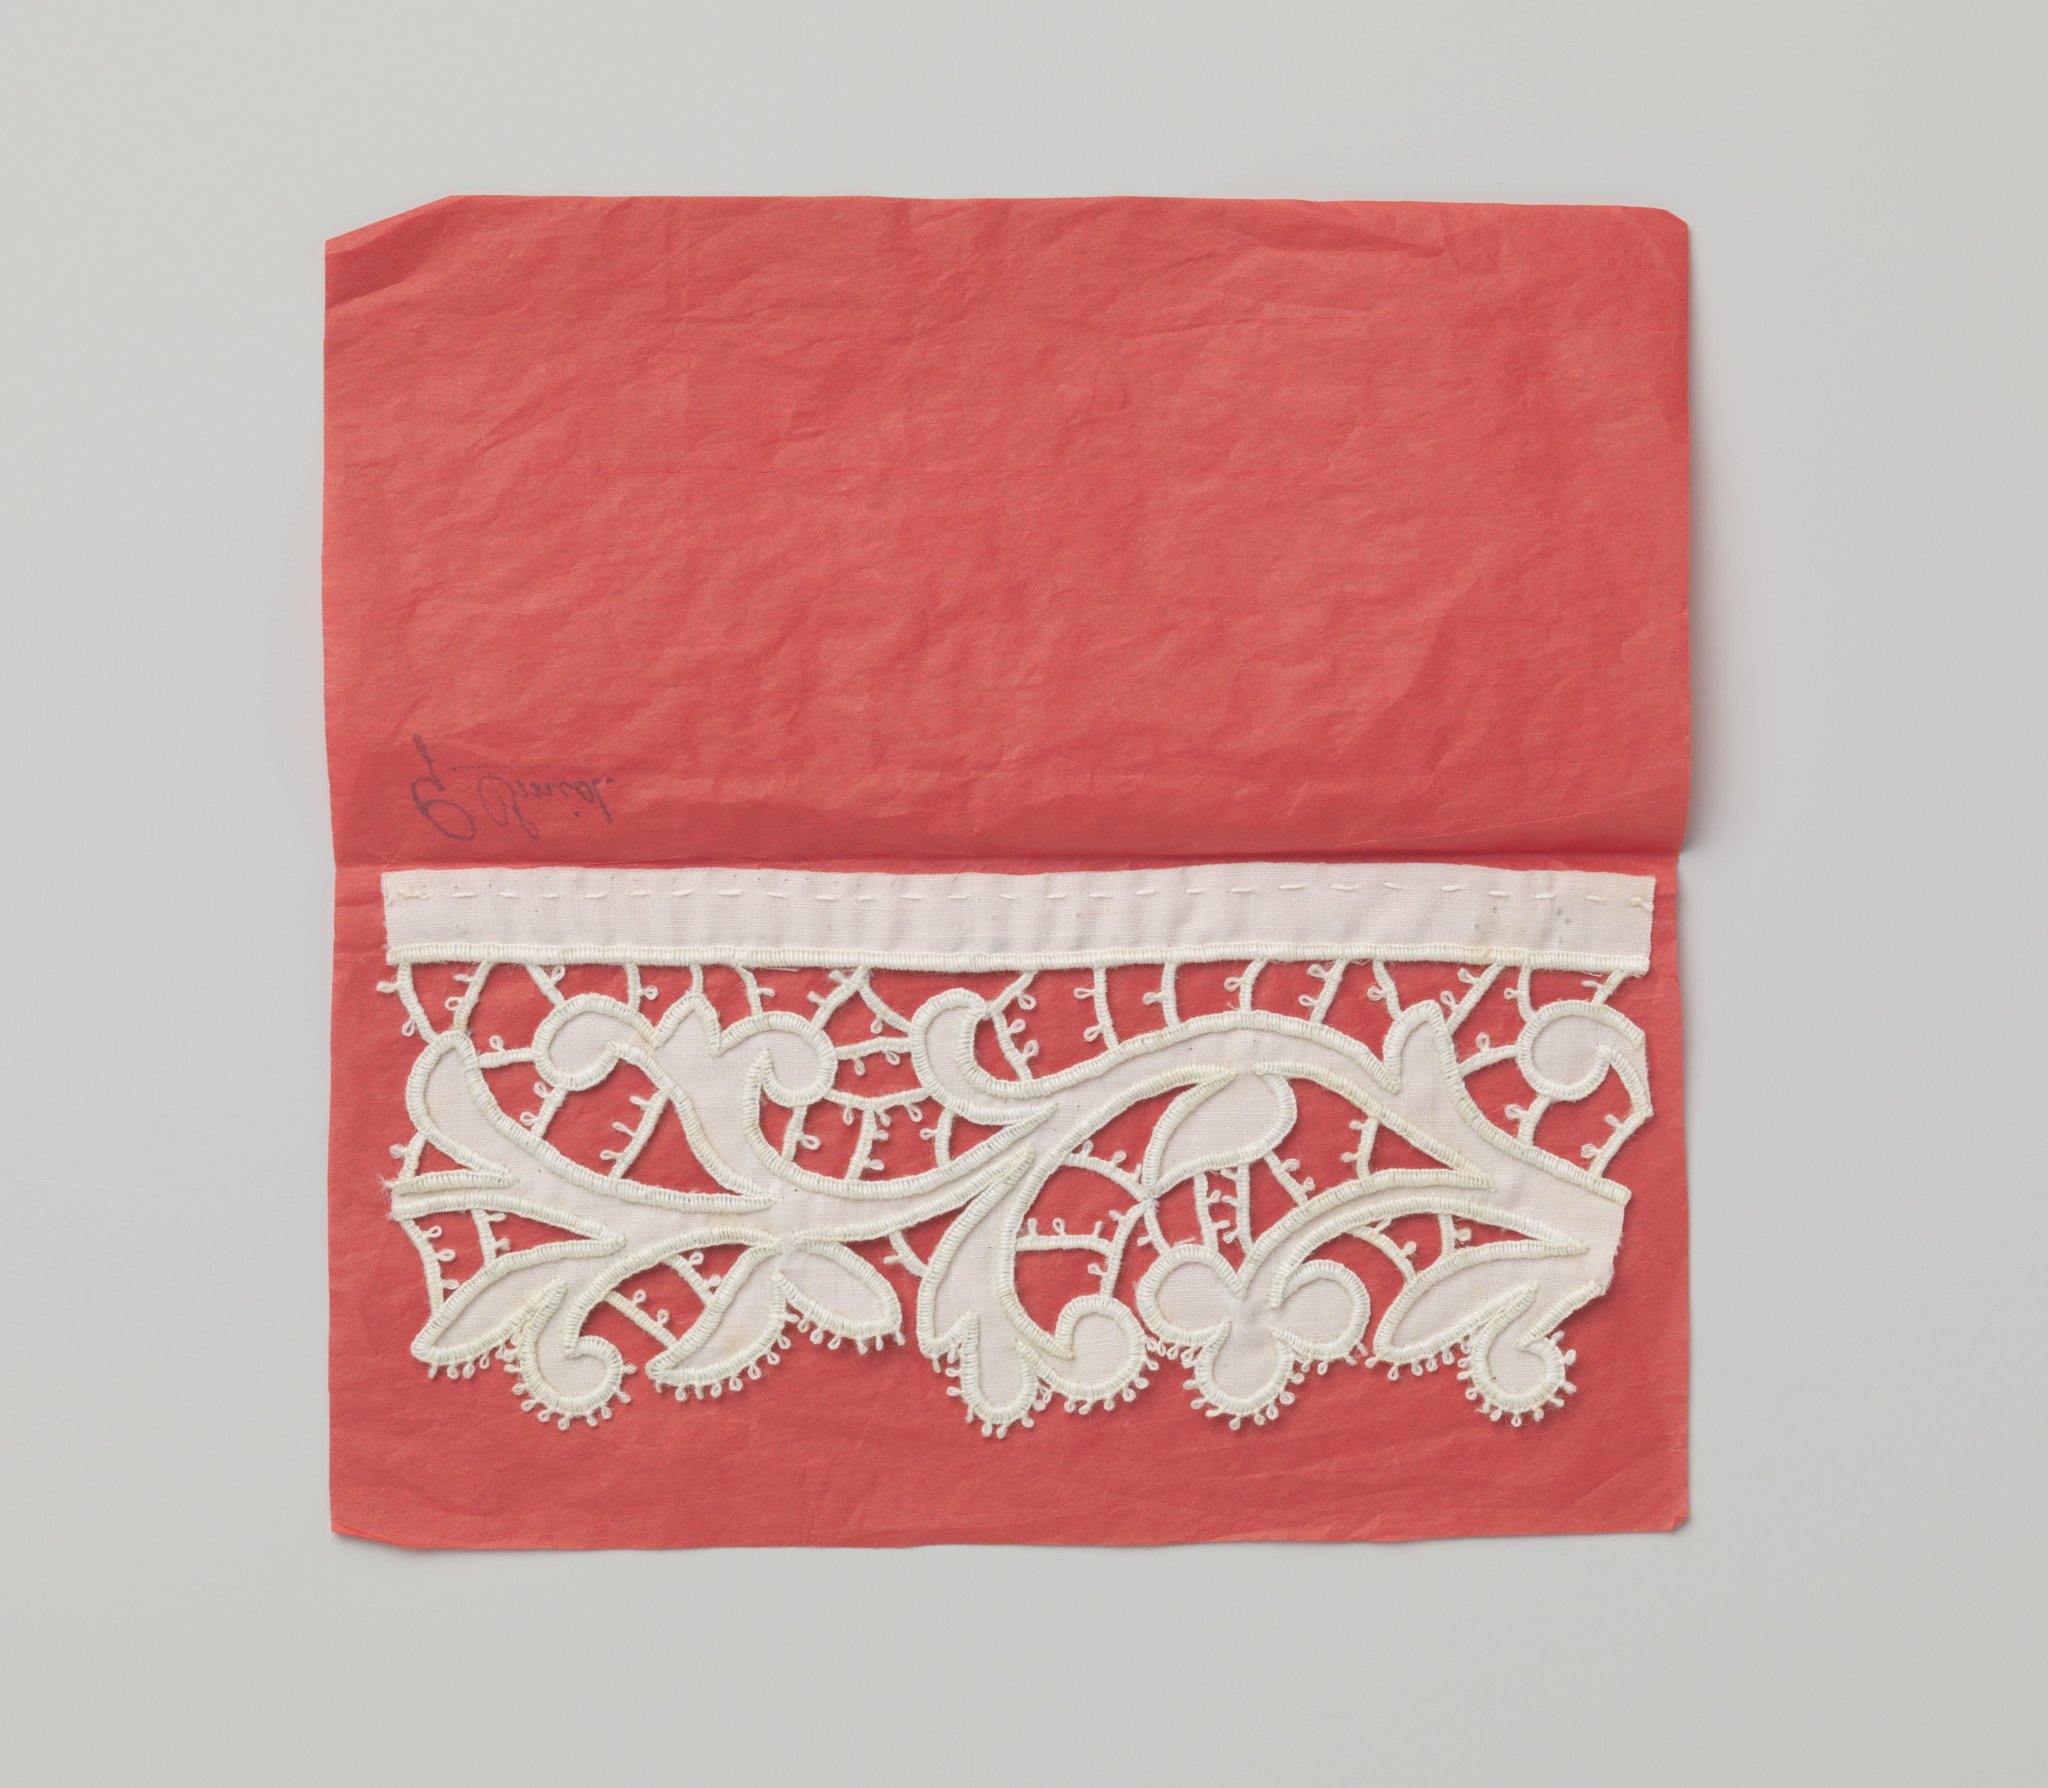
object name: werkstuk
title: Werkstuk voor Diploma fraaie handwerken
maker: geesje smid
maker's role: artisan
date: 1890-1900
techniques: embroidered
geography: netherlands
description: Strook Richelieuwerk met golvende tak met bladeren, waaronder een drieblad.